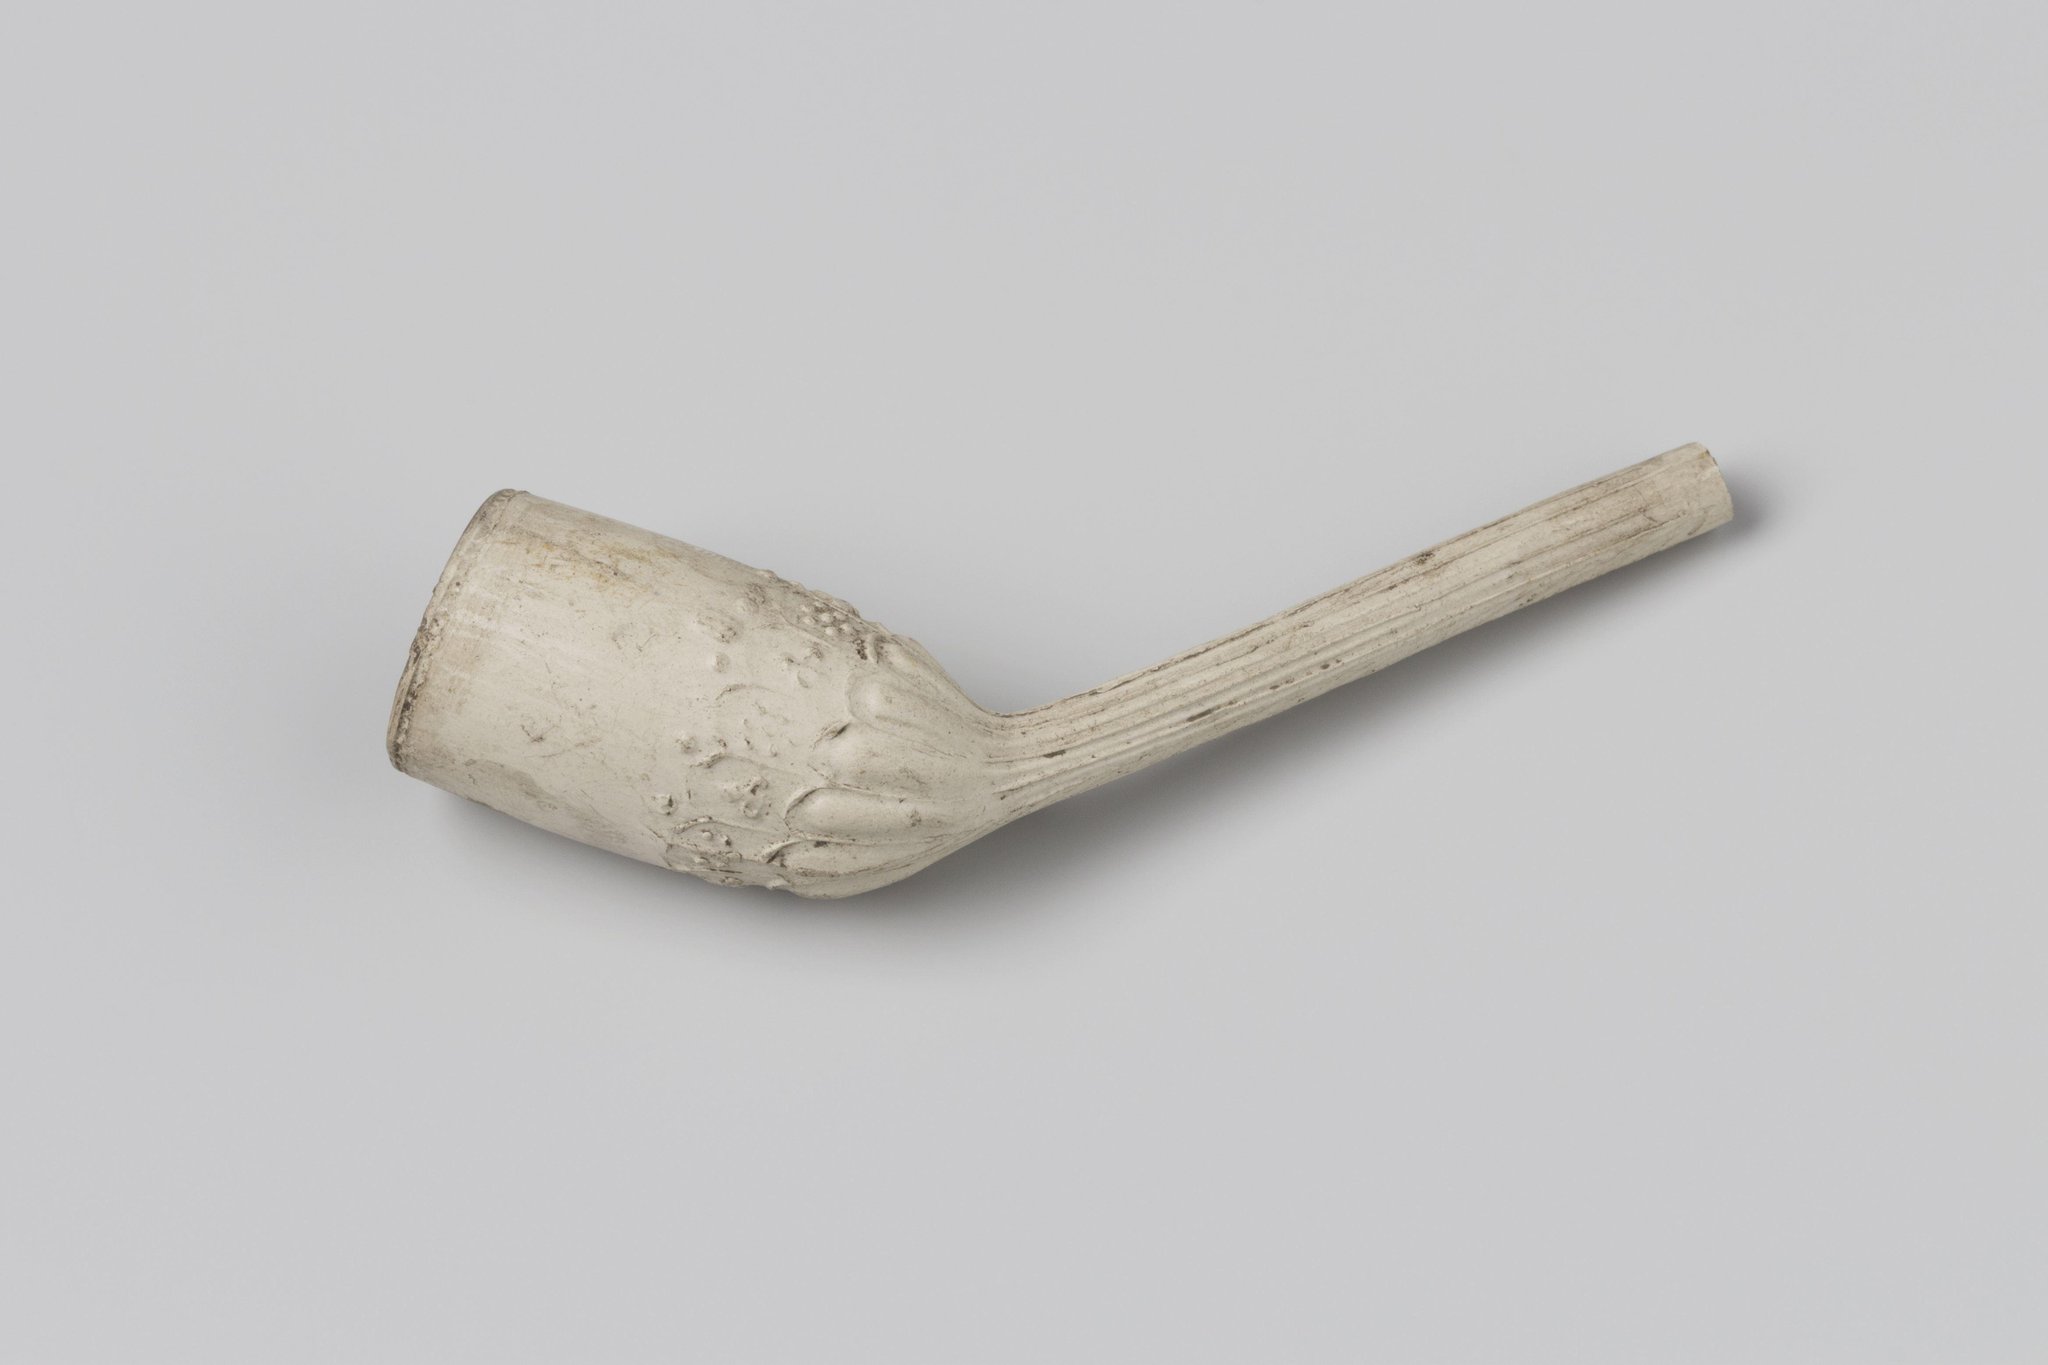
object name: fragment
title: Fragment tabakspijp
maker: jan nieuwveld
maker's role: pijpenfabrikant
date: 1740-1780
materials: clay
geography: gouda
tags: directeur, hoogleraar, caspar jacob christiaan reuvens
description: Fragment tabakspijp met knorren (floraal uitwaaiend motief) in omlijning, aan de bovenzijde eindigend in boogjes waarin afwisselend gestileerde roosjes en lelies en boven de boogjes een rij bloempjes. Van de opgravingen op de Hofstede Arentsburg 1827-1831 onder toezicht van Professor Reuvens.